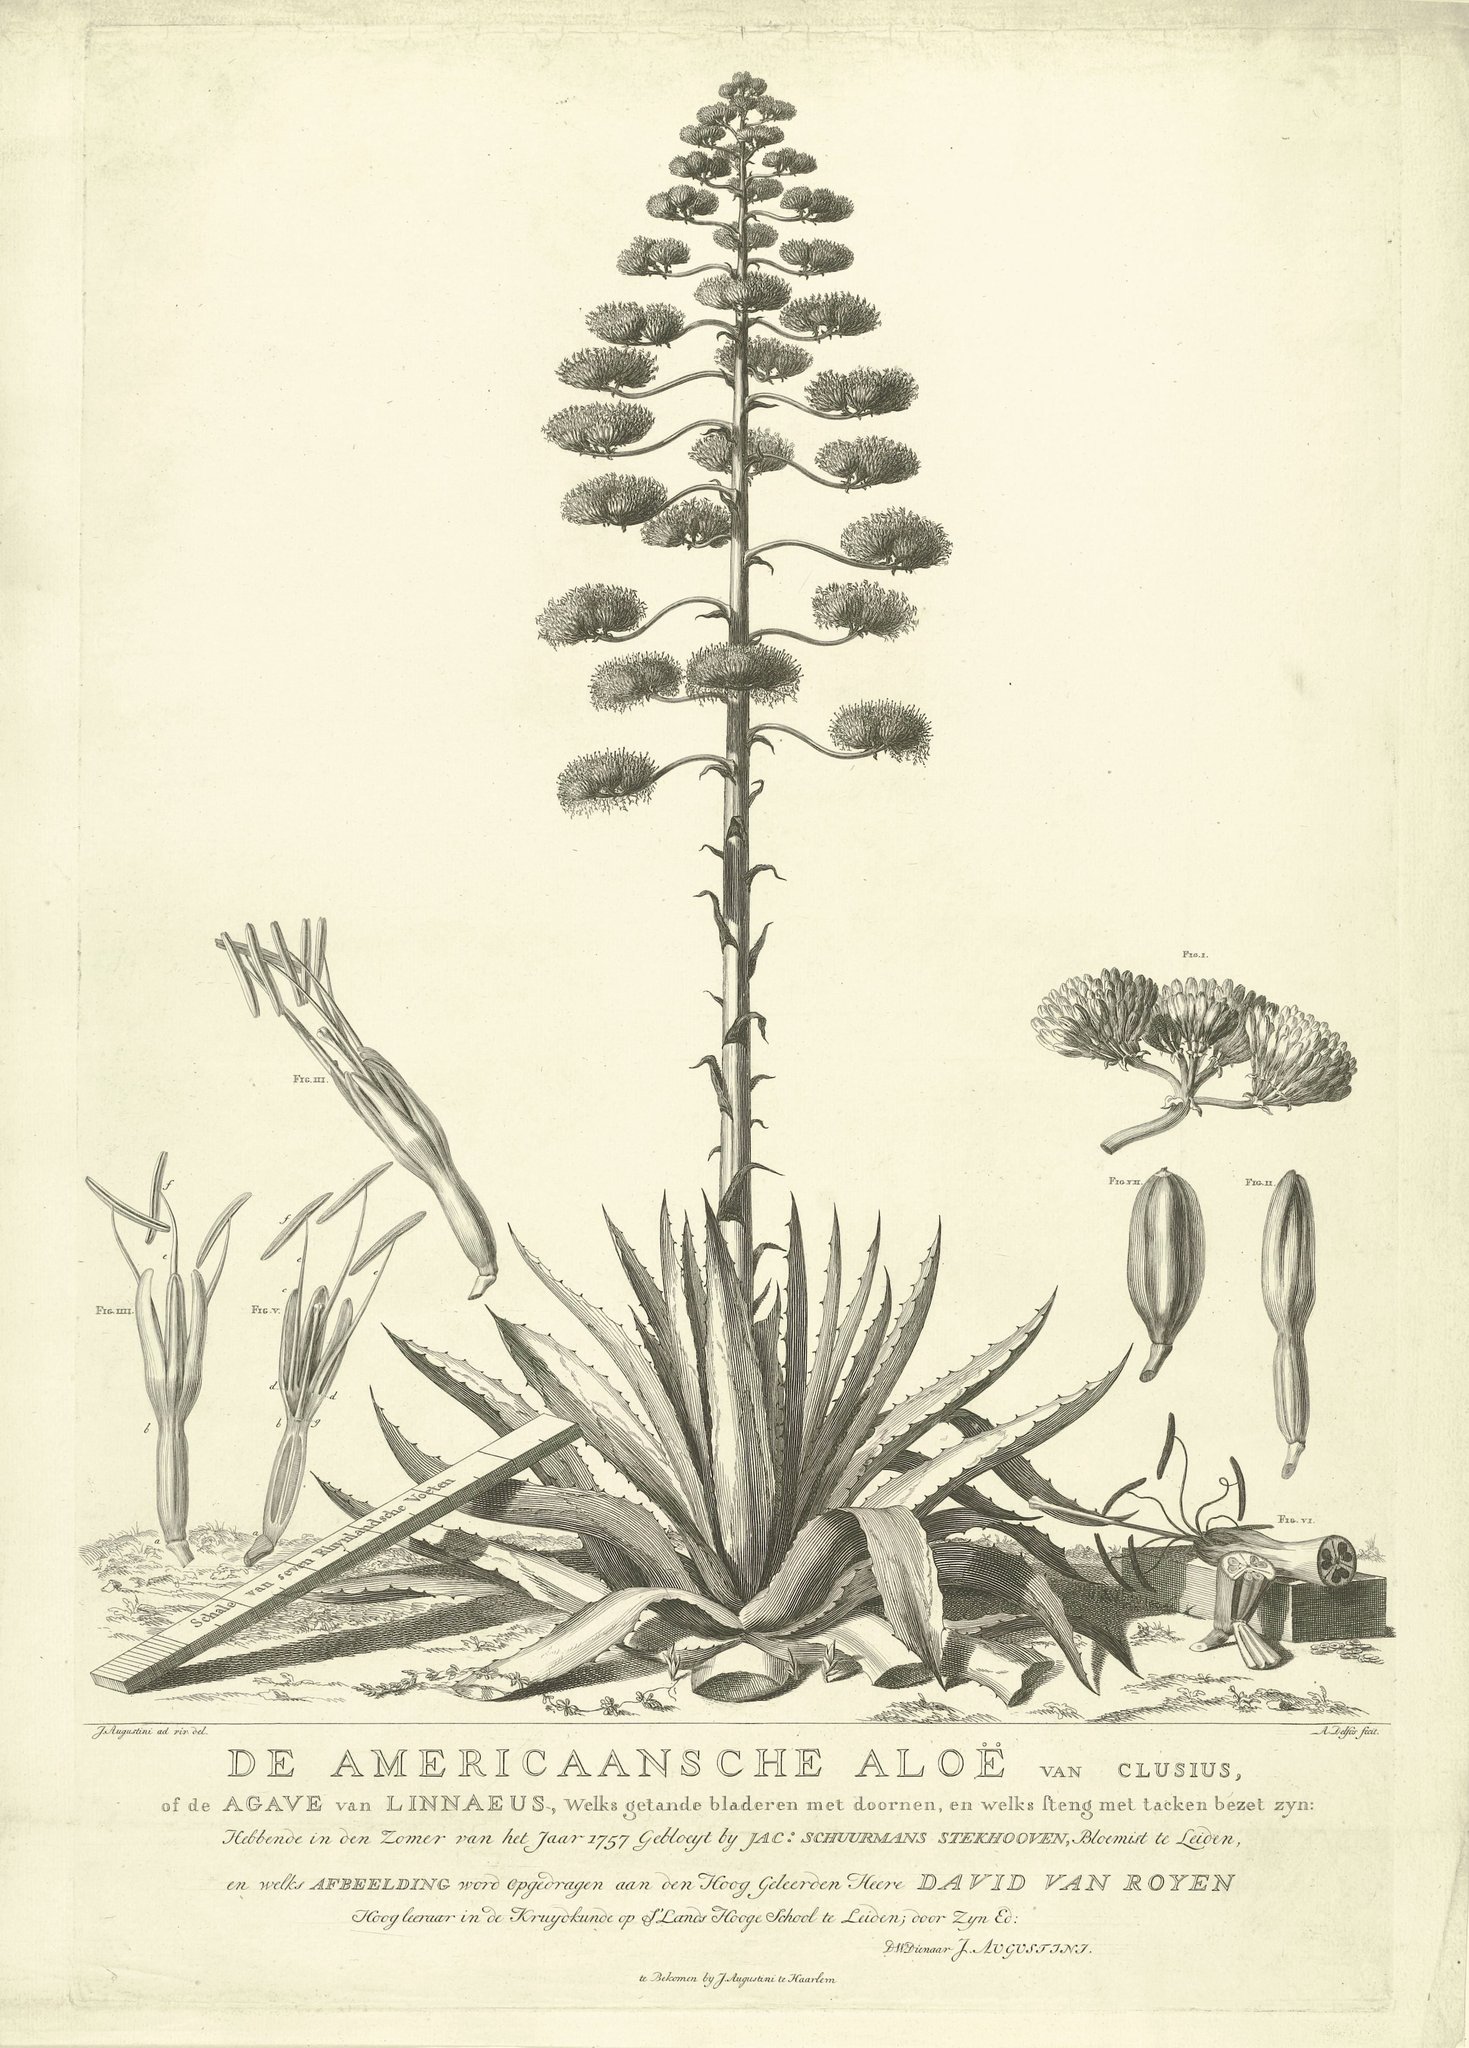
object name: print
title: Bloeiende Amerikaanse Aloë, 1757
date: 1757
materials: paper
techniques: engraving, etching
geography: northern netherlands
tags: plants; vegetation (+ flowers, blossom, blossoming)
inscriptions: collector's mark: Lugt 2228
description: Een Amerikaanse Aloë of Agave die in de zomer van 1757 gebloeid heeft bij de Leidse bloemenkweker Jacobus Schuurmans Stekhoven. In het onderschrift de titel en opdracht aan de Leidse botanist David van Royen. Bij de prent behoort een blad met uitleg.